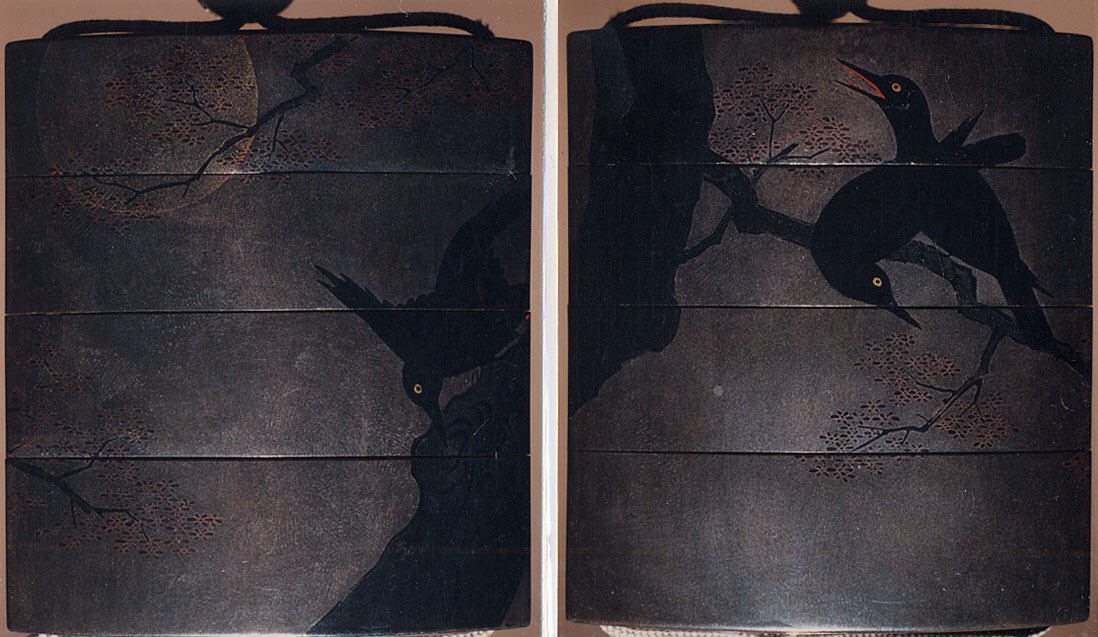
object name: inrō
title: Inrō with Crows on Tree in Moonlight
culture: japanese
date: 1701-1900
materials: gold, ivory, lacquer, silver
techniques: carving, maki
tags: birds,moon,trees